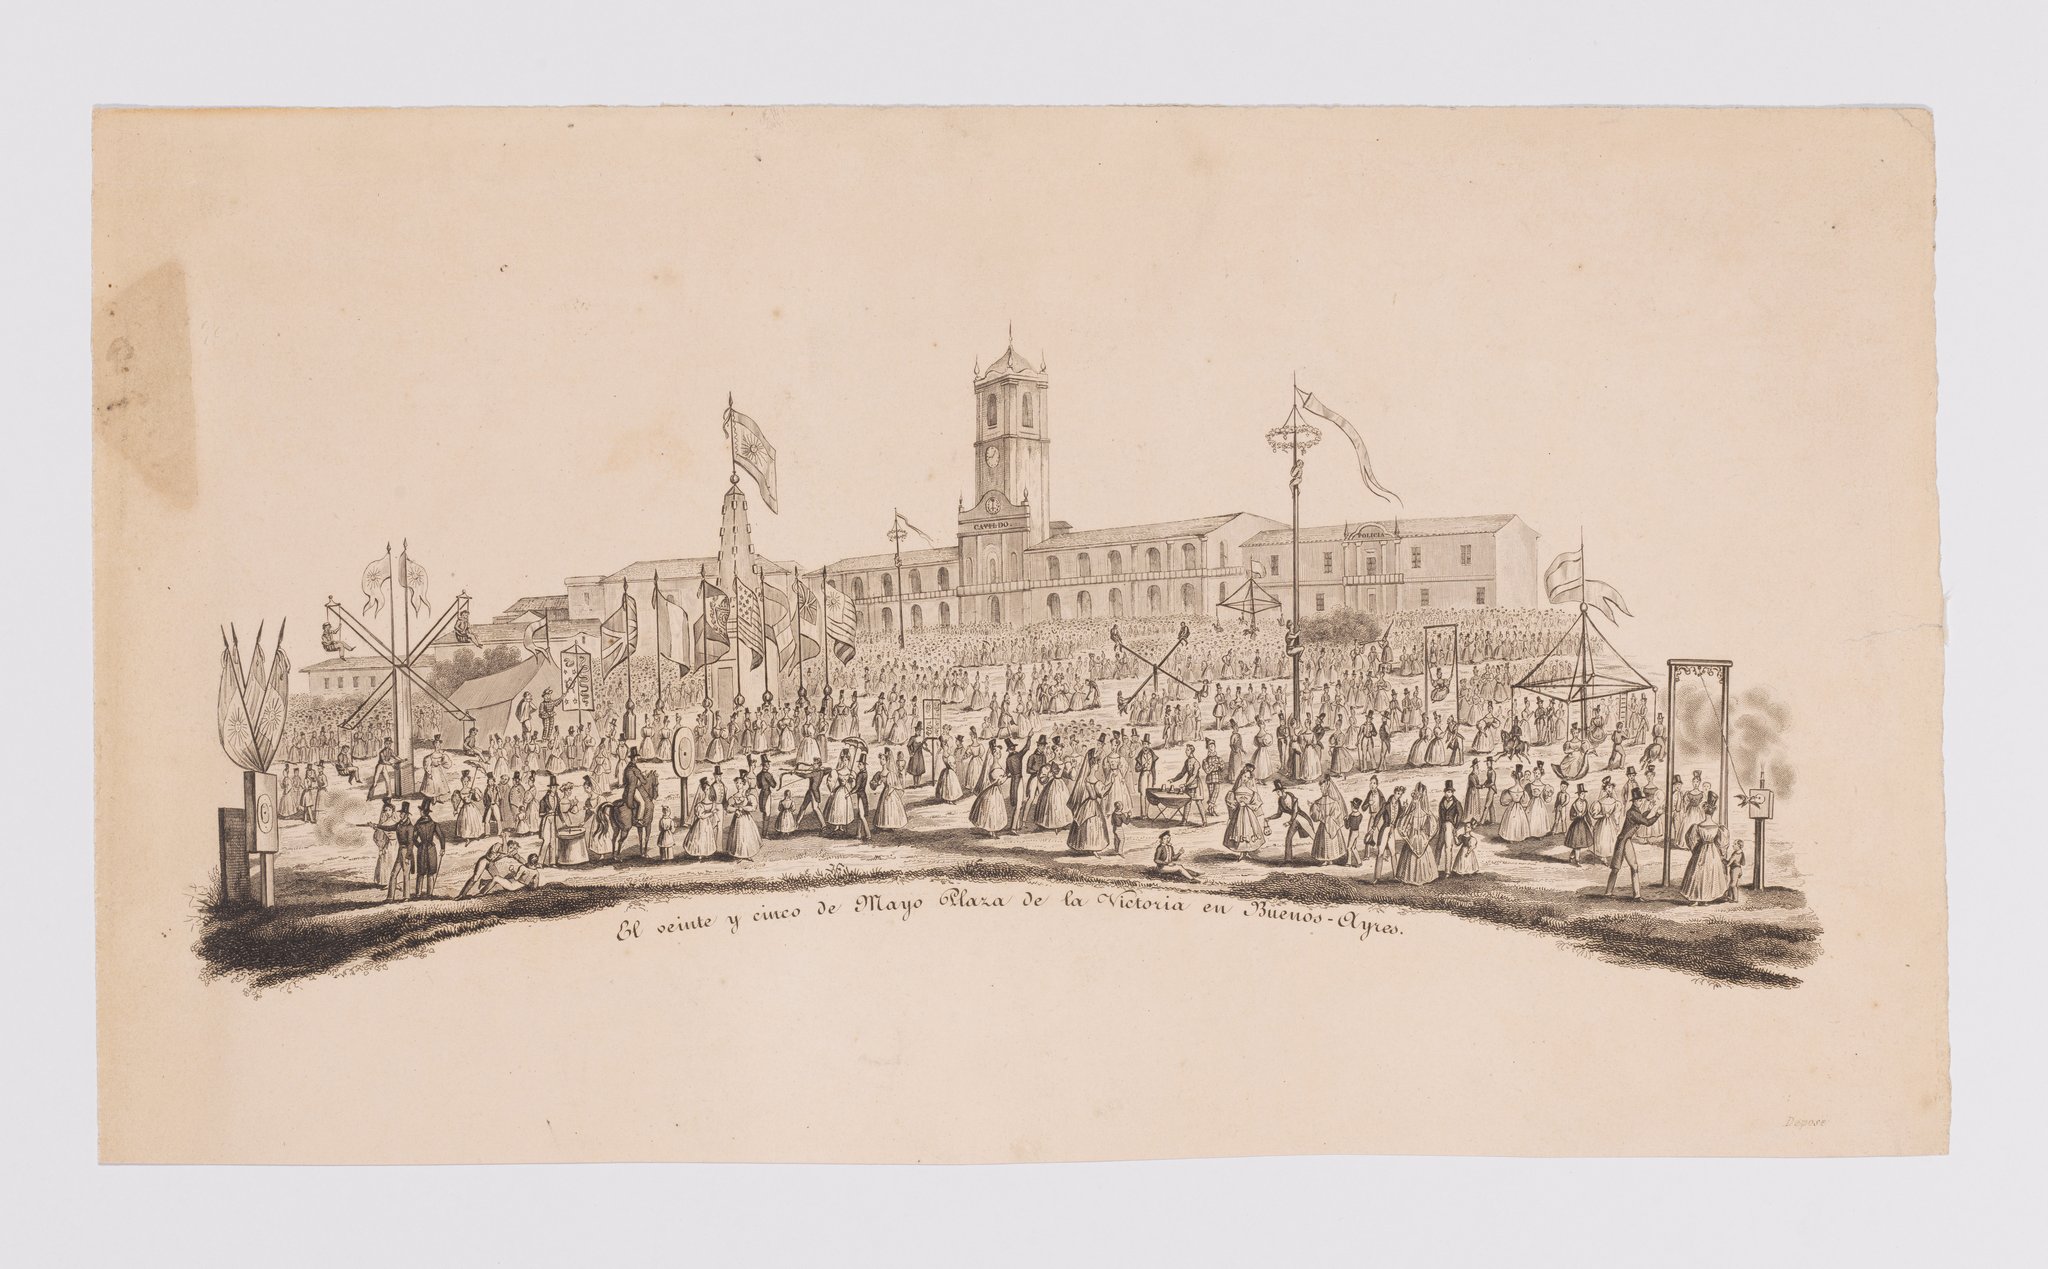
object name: print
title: Fan leaf depicting the fair at Buenos-Ayres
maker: anonymous, french, 19th century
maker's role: artist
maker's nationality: french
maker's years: 1800-1900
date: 1801-1900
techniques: etching